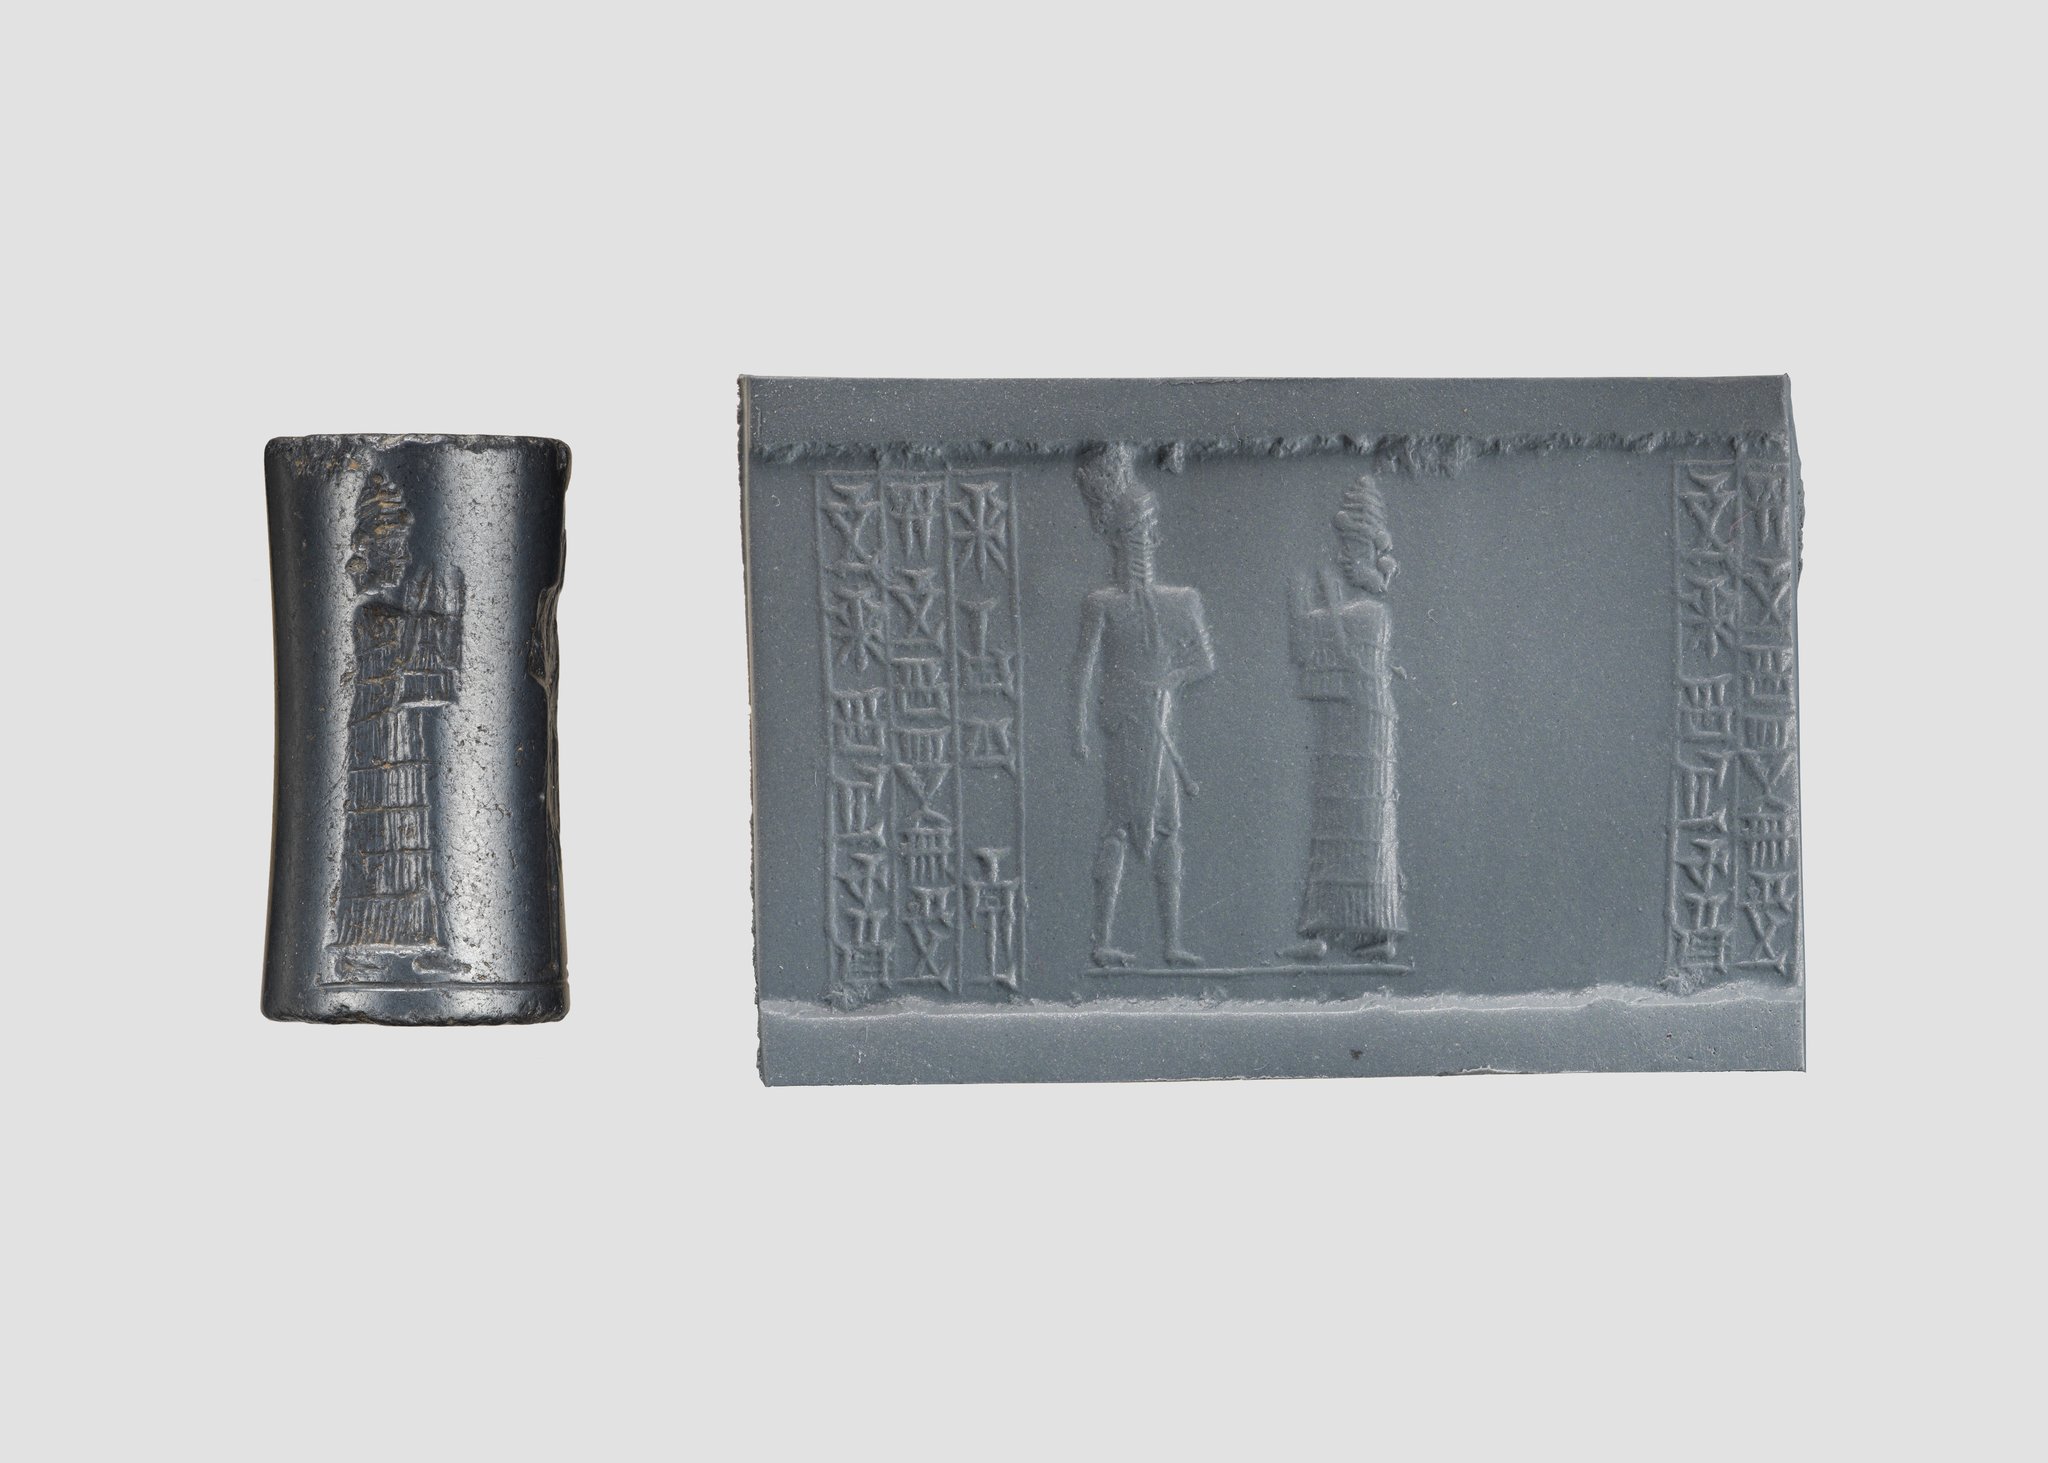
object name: cylinder seal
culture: babylonian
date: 2000-1668 BCE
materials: mineral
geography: mesopotamia